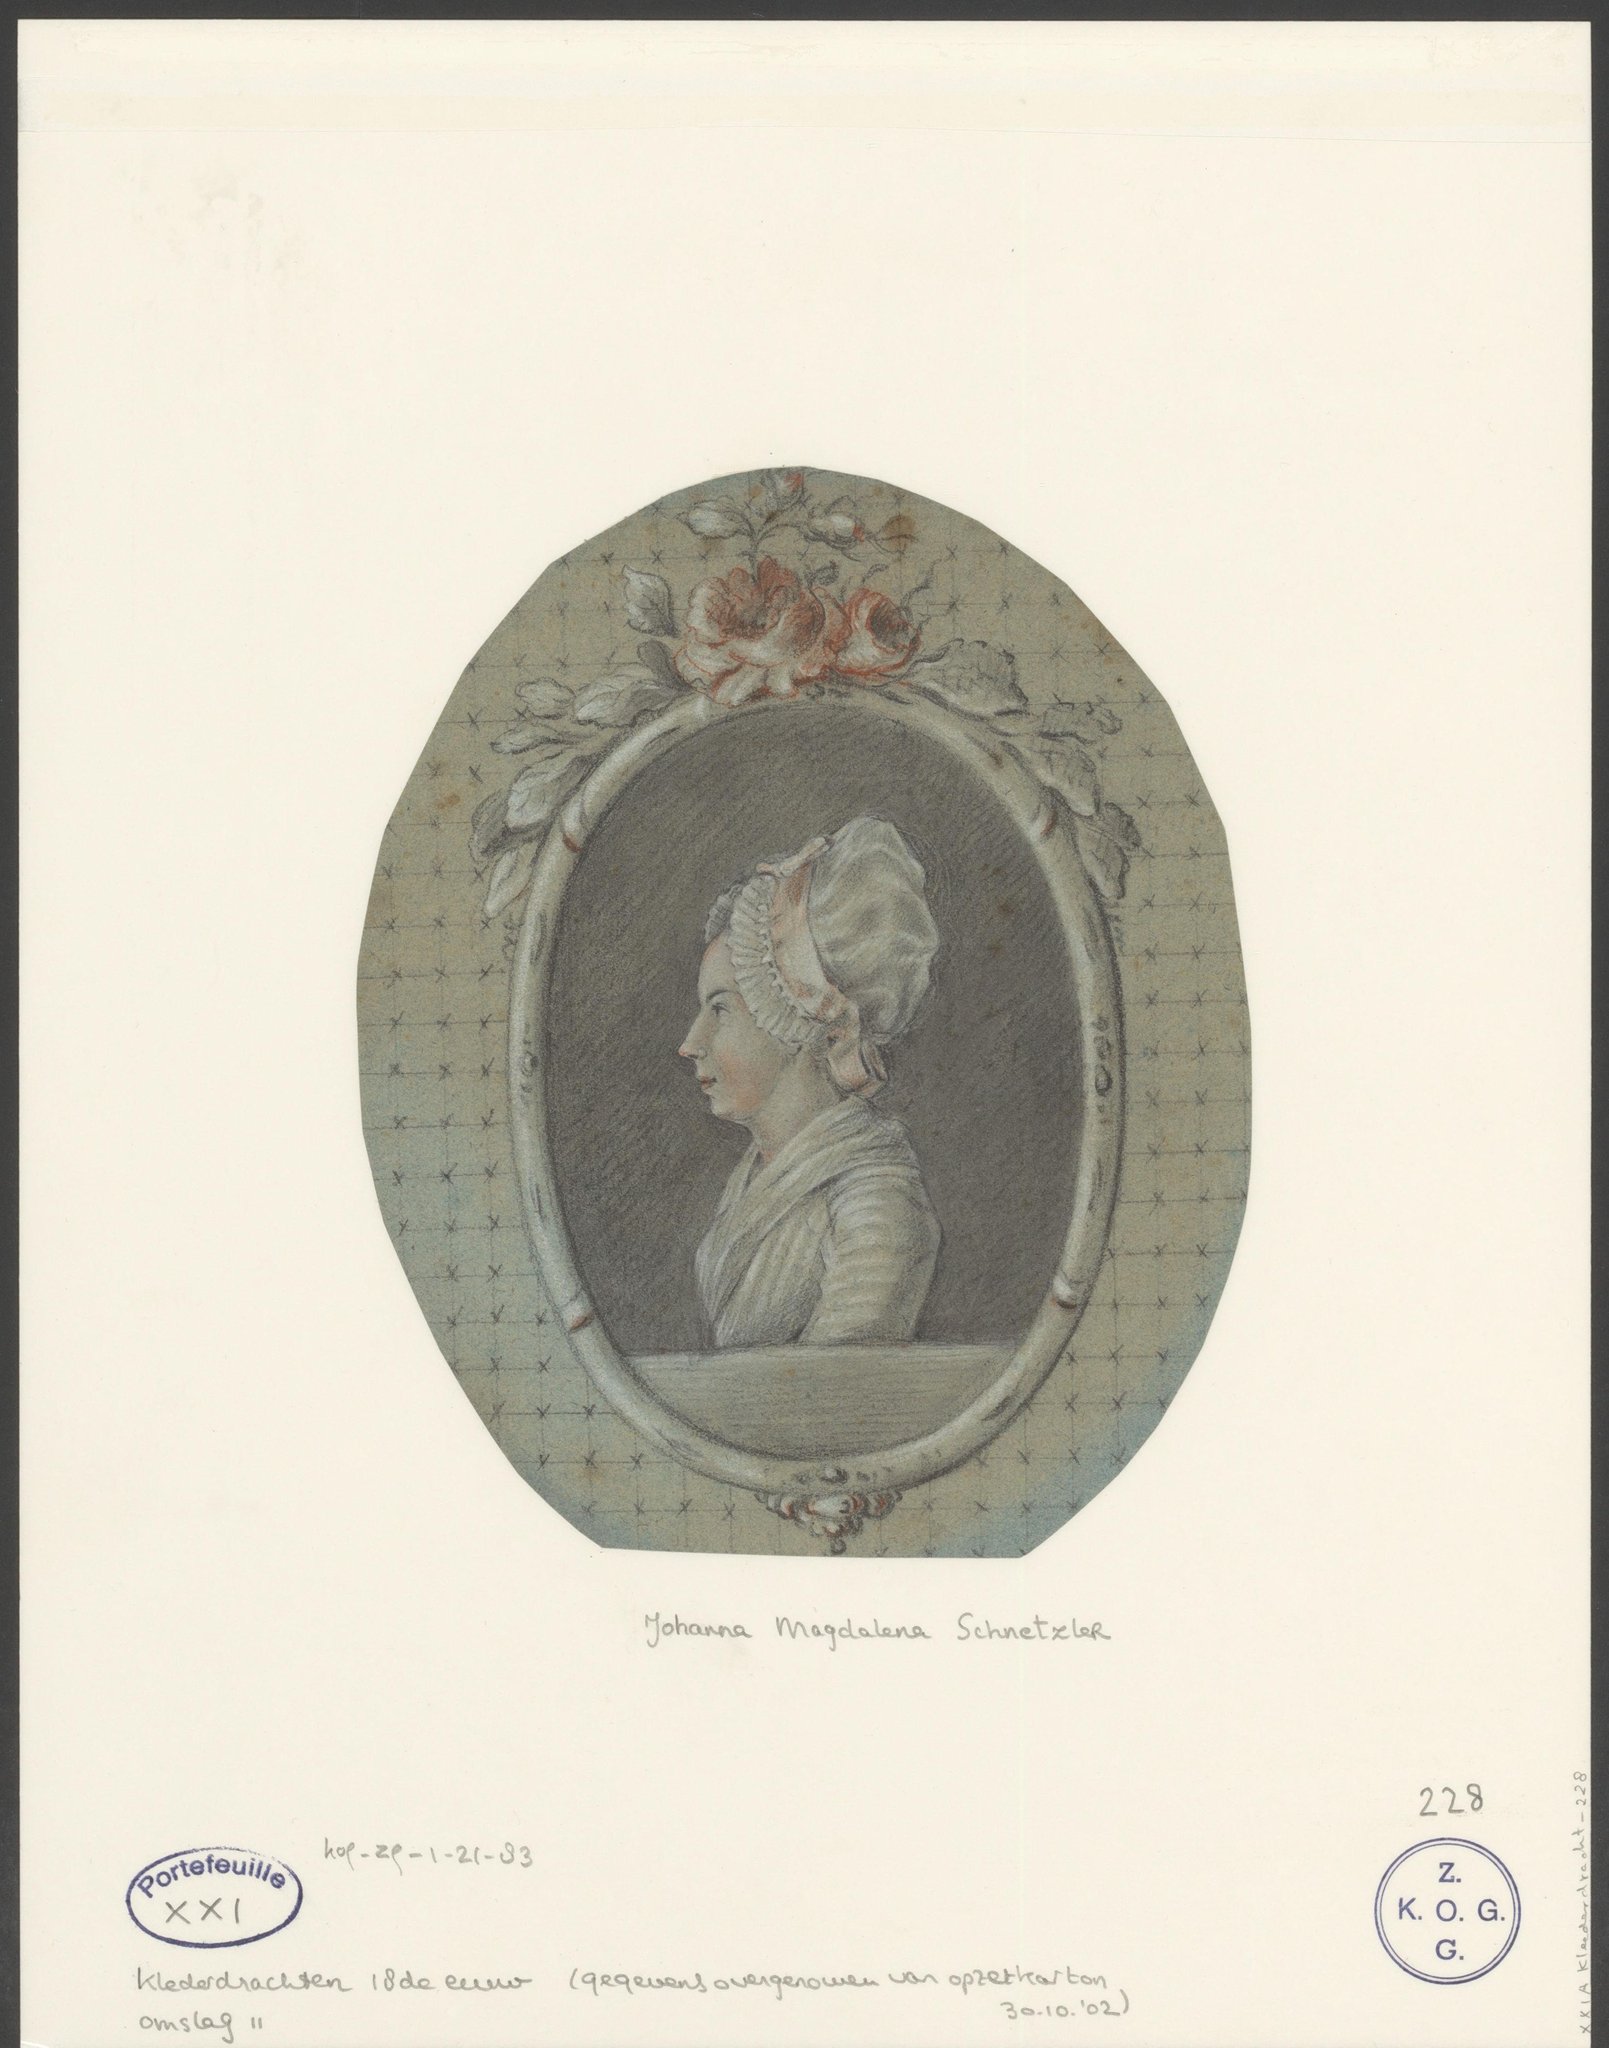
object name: drawing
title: Portret van Johanna Magdalena Schnetzler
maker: Anonymous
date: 1784-1843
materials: chalk, paper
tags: johanna magdalena schnetzler, historical persons - bb - woman, head-gear: hat, flowers: rose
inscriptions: stamp, collector's mark: Lugt 1641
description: Onderwerpsrubrieken binnen de Atlas Zeden en Gewoonten: Zeden en Gewoonten in Engeren Zin, De Kleeding, Kleederdrachten (tijdvakken), De 18de eeuw (de pruikentijd). Mannen en vrouwen.